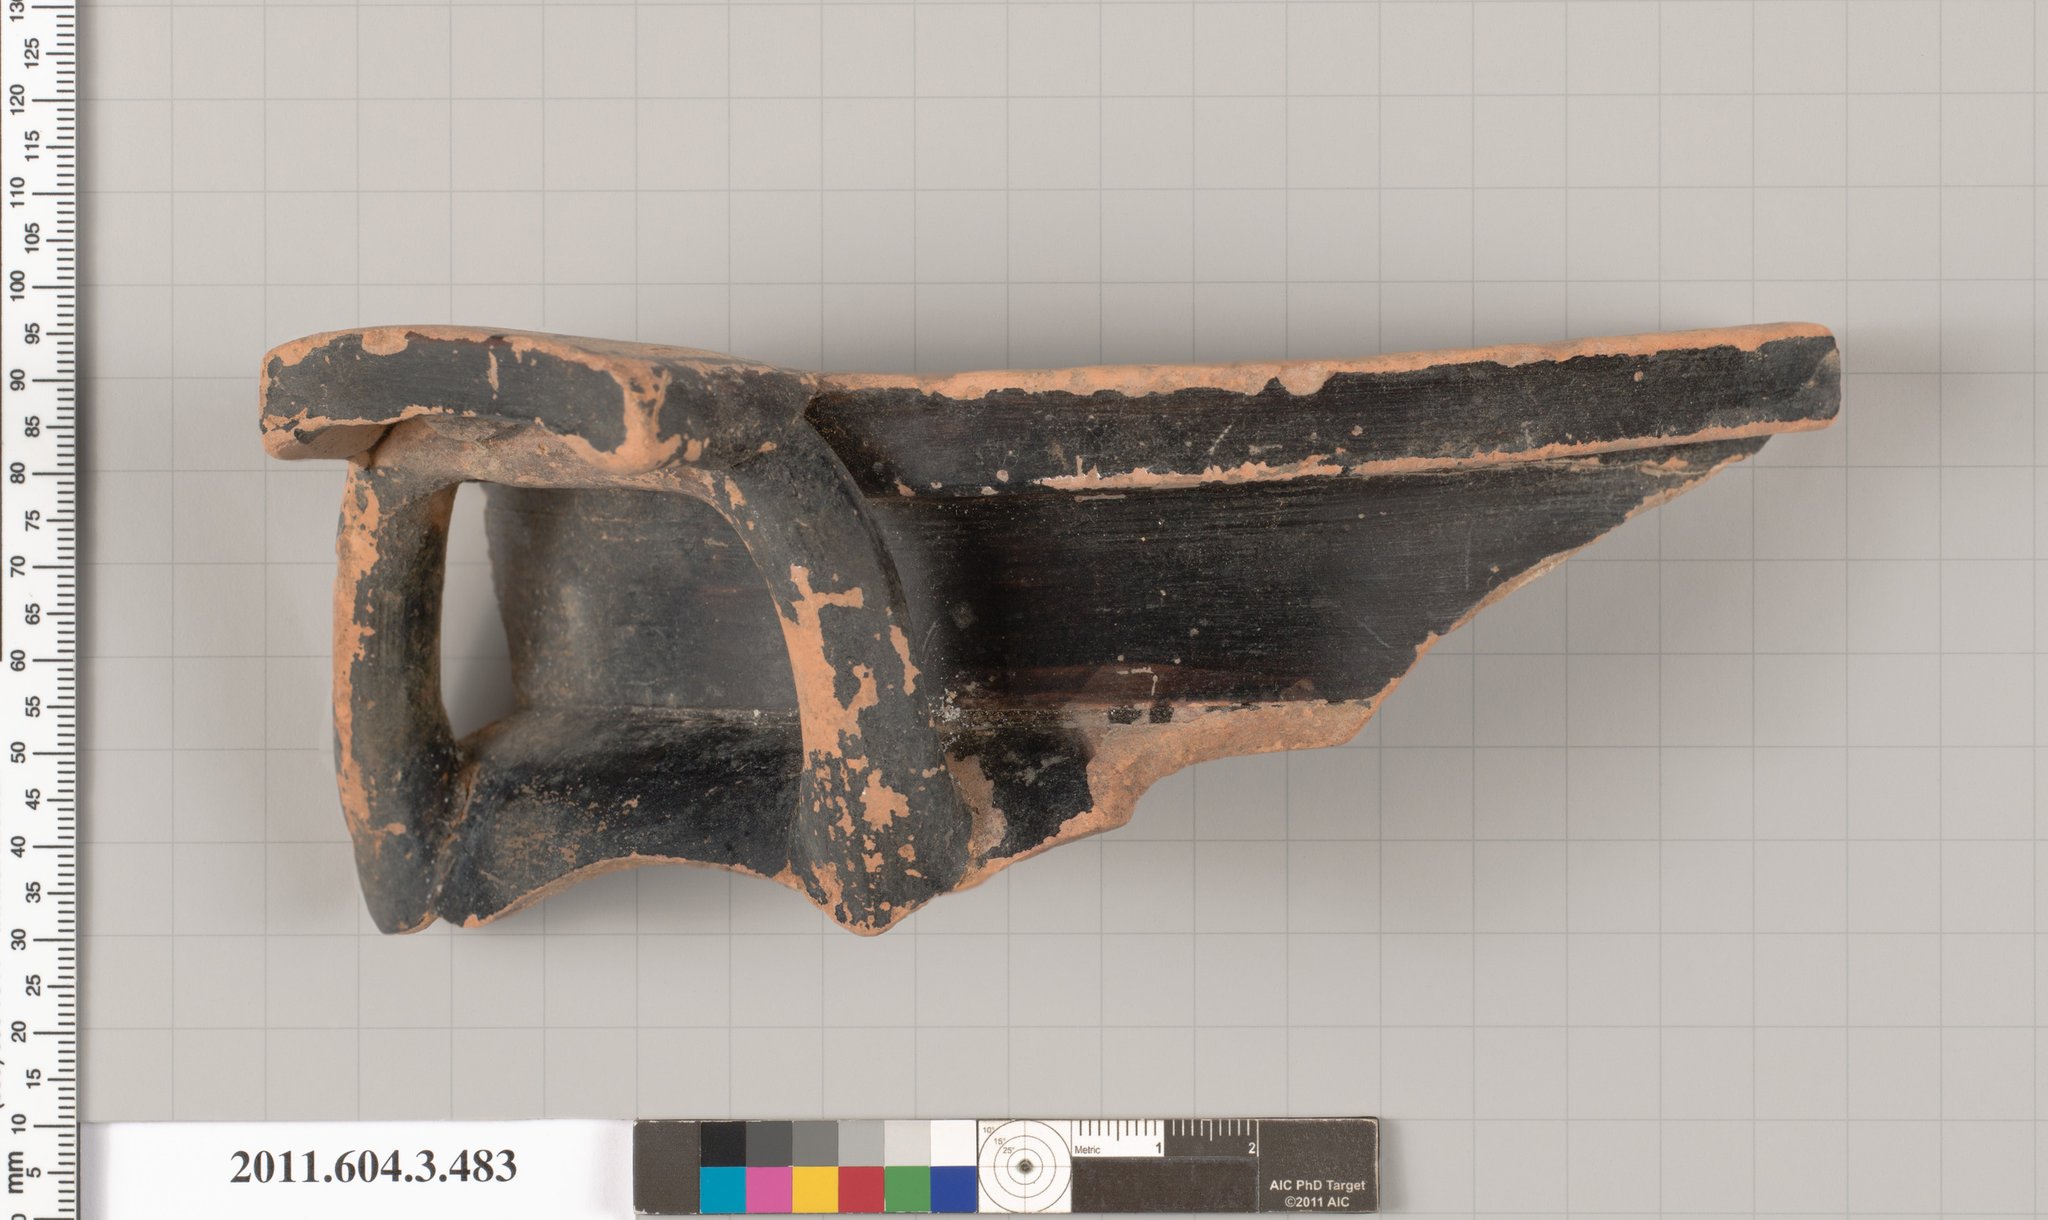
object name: column krater fragment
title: Terracotta fragment of a column-krater (bowl for mixing wine and water)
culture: greek, attic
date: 600-576 BCE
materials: terracotta